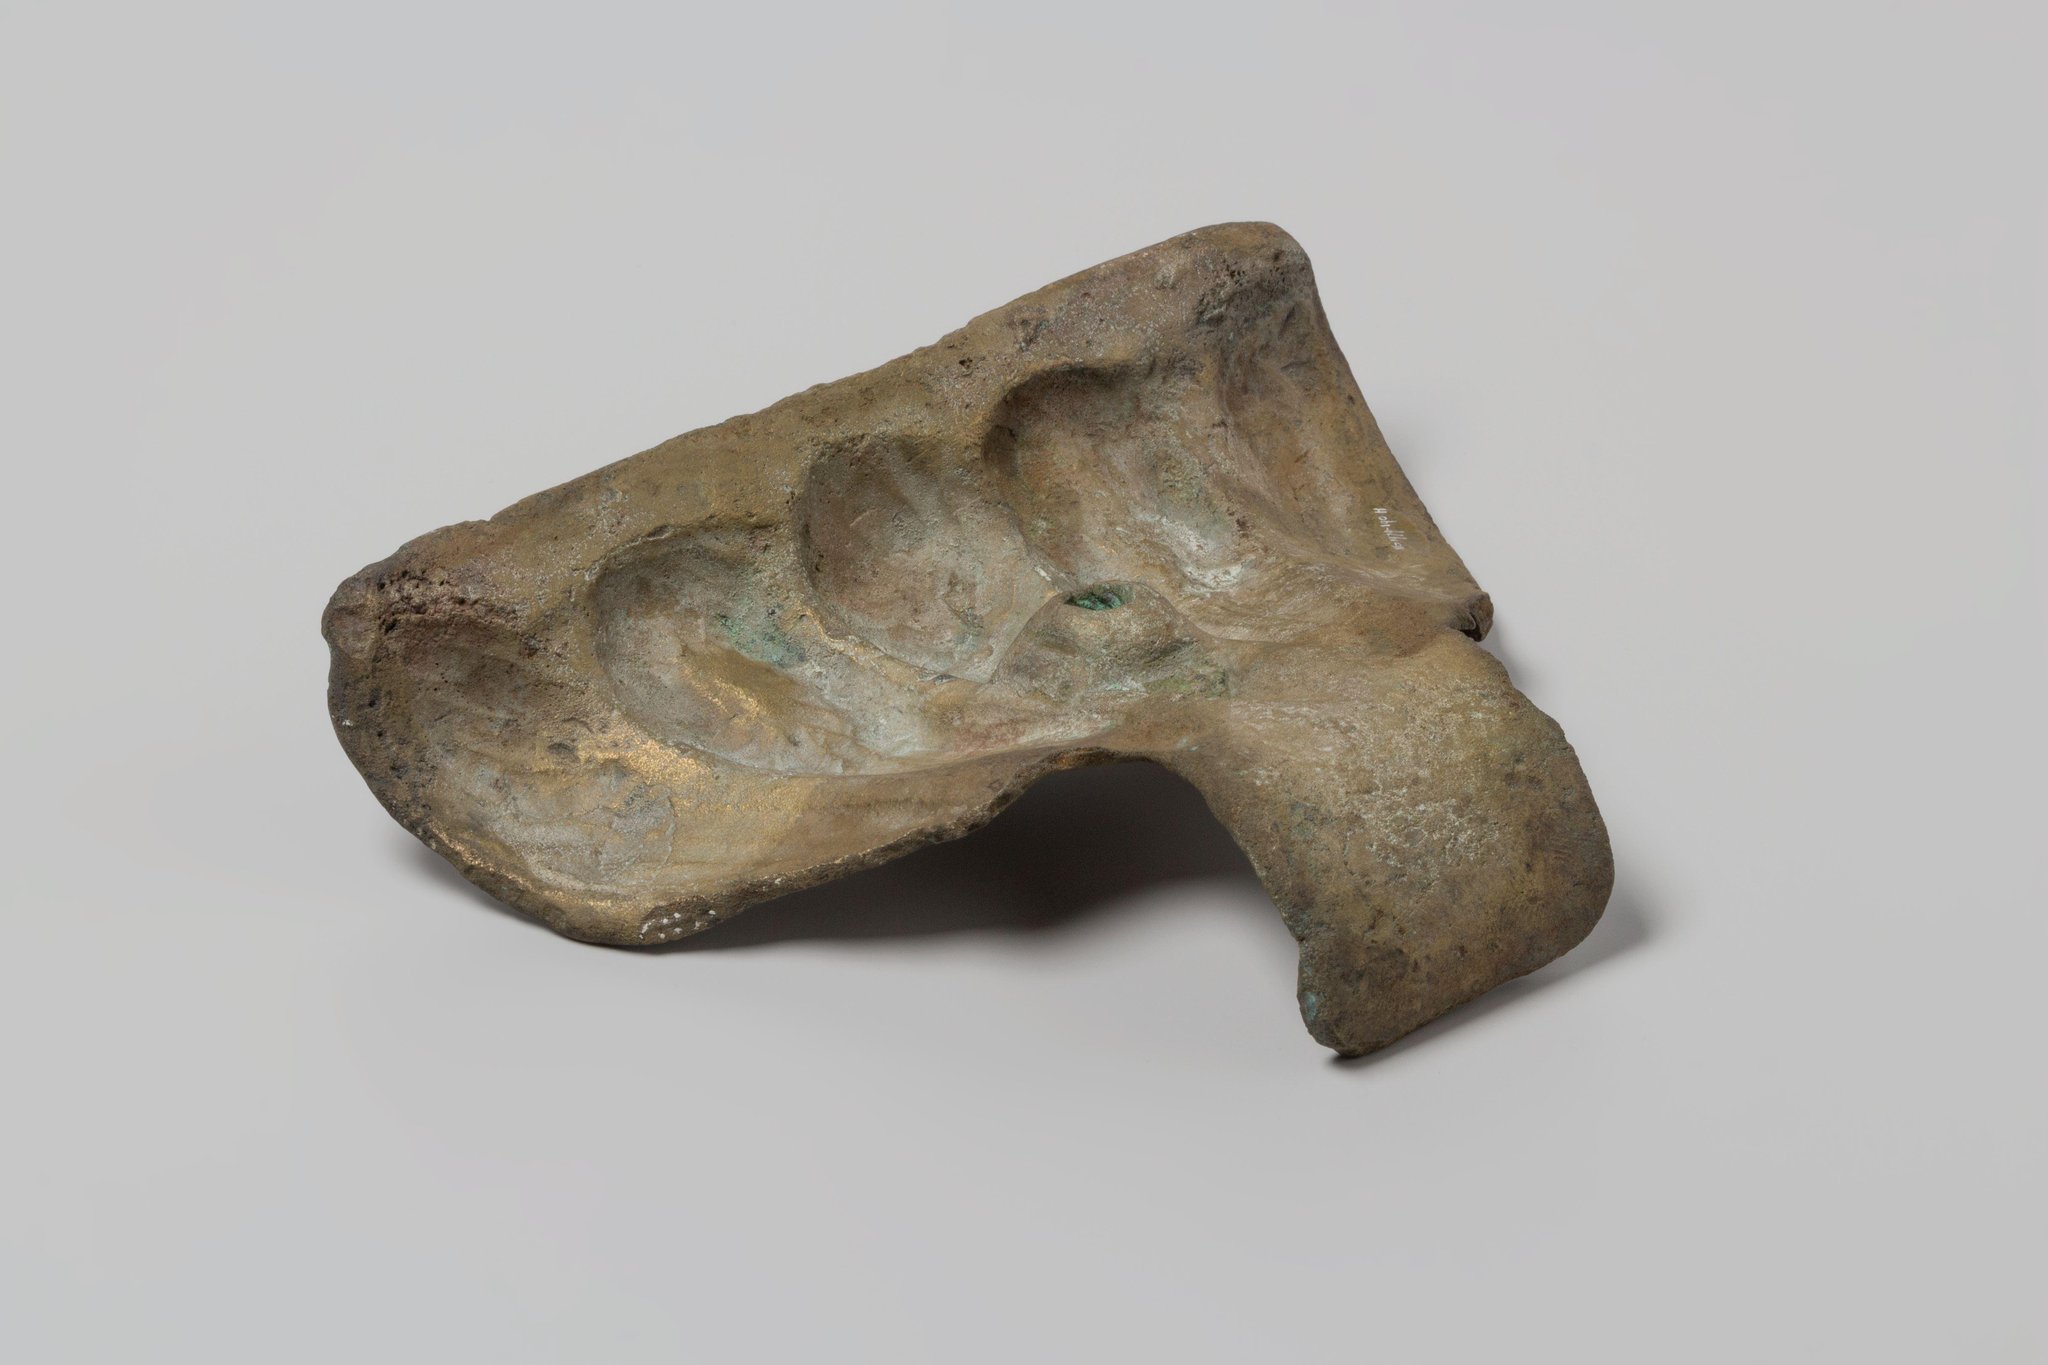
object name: mould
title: Mal uit het wrak van de Oost-Indiëvaarder Hollandia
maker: Anonymous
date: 1700-1743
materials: copper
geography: netherlands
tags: verenigde oostindische compagnie, hollandia (schip), annet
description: Tools and instruments, lead casting, mould; countermould of mould NG 1979-167H1062, eroded, curved, on the reverse handle fitting id. NG 1979-192H3074.